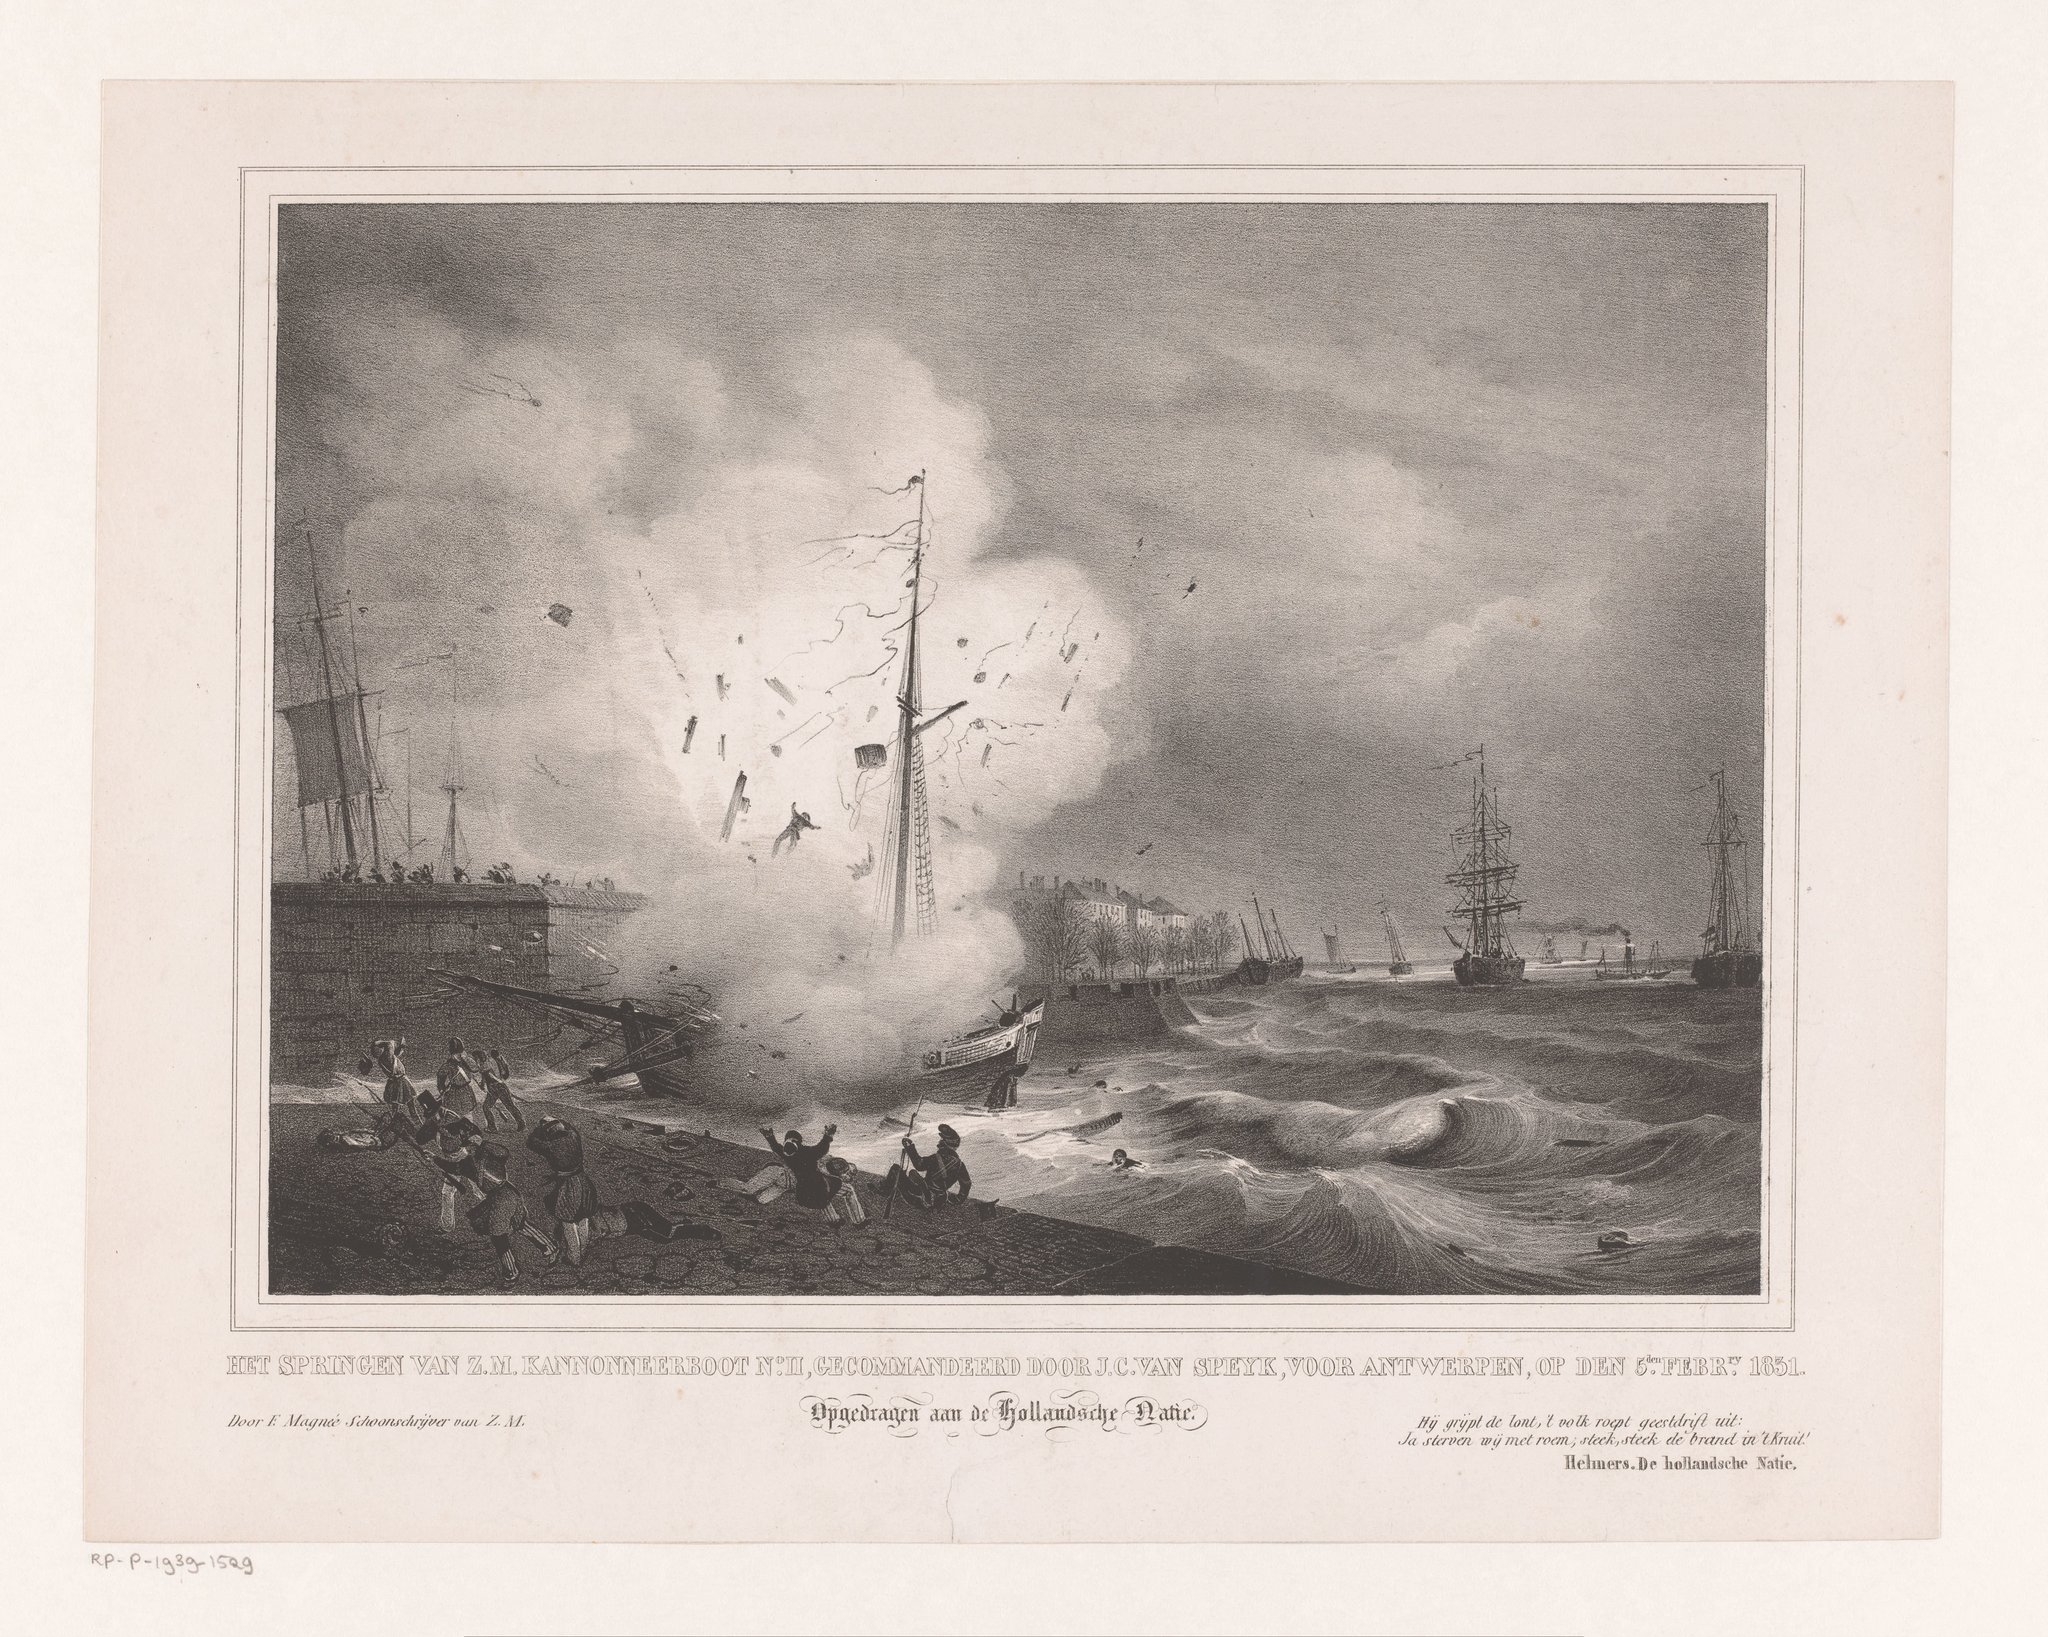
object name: print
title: Het springen van Z.M. kannonneerboot No. II, gecommandeerd door J. C. van Speyck, voor Antwerpen, op den 5den febr.ry 1831.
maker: françois magneé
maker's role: print maker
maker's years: 1798-1865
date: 1831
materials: paper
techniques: lithograph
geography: brussels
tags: amsterdam, antwerp, jan van speyk, harbour, projectiles, explosives, etc.: gunpowder (+ sailing-ships)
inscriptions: collector's mark: Lugt 2166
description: Het schip is gehuld in stofwolken. Brokstukken en personen vliegen door de lucht. Op de kade rennen soldaten en burgers voor hun leven. Rechts op zee meer schepen. Onder de afbeelding: Opgedragen aan de Hollandsche Natie. Rechtsonder twee dichtregels door Jan Frederik Helmers (1767-1813) uit het lofdicht 'De Hollandsche Natie' uit 1813.